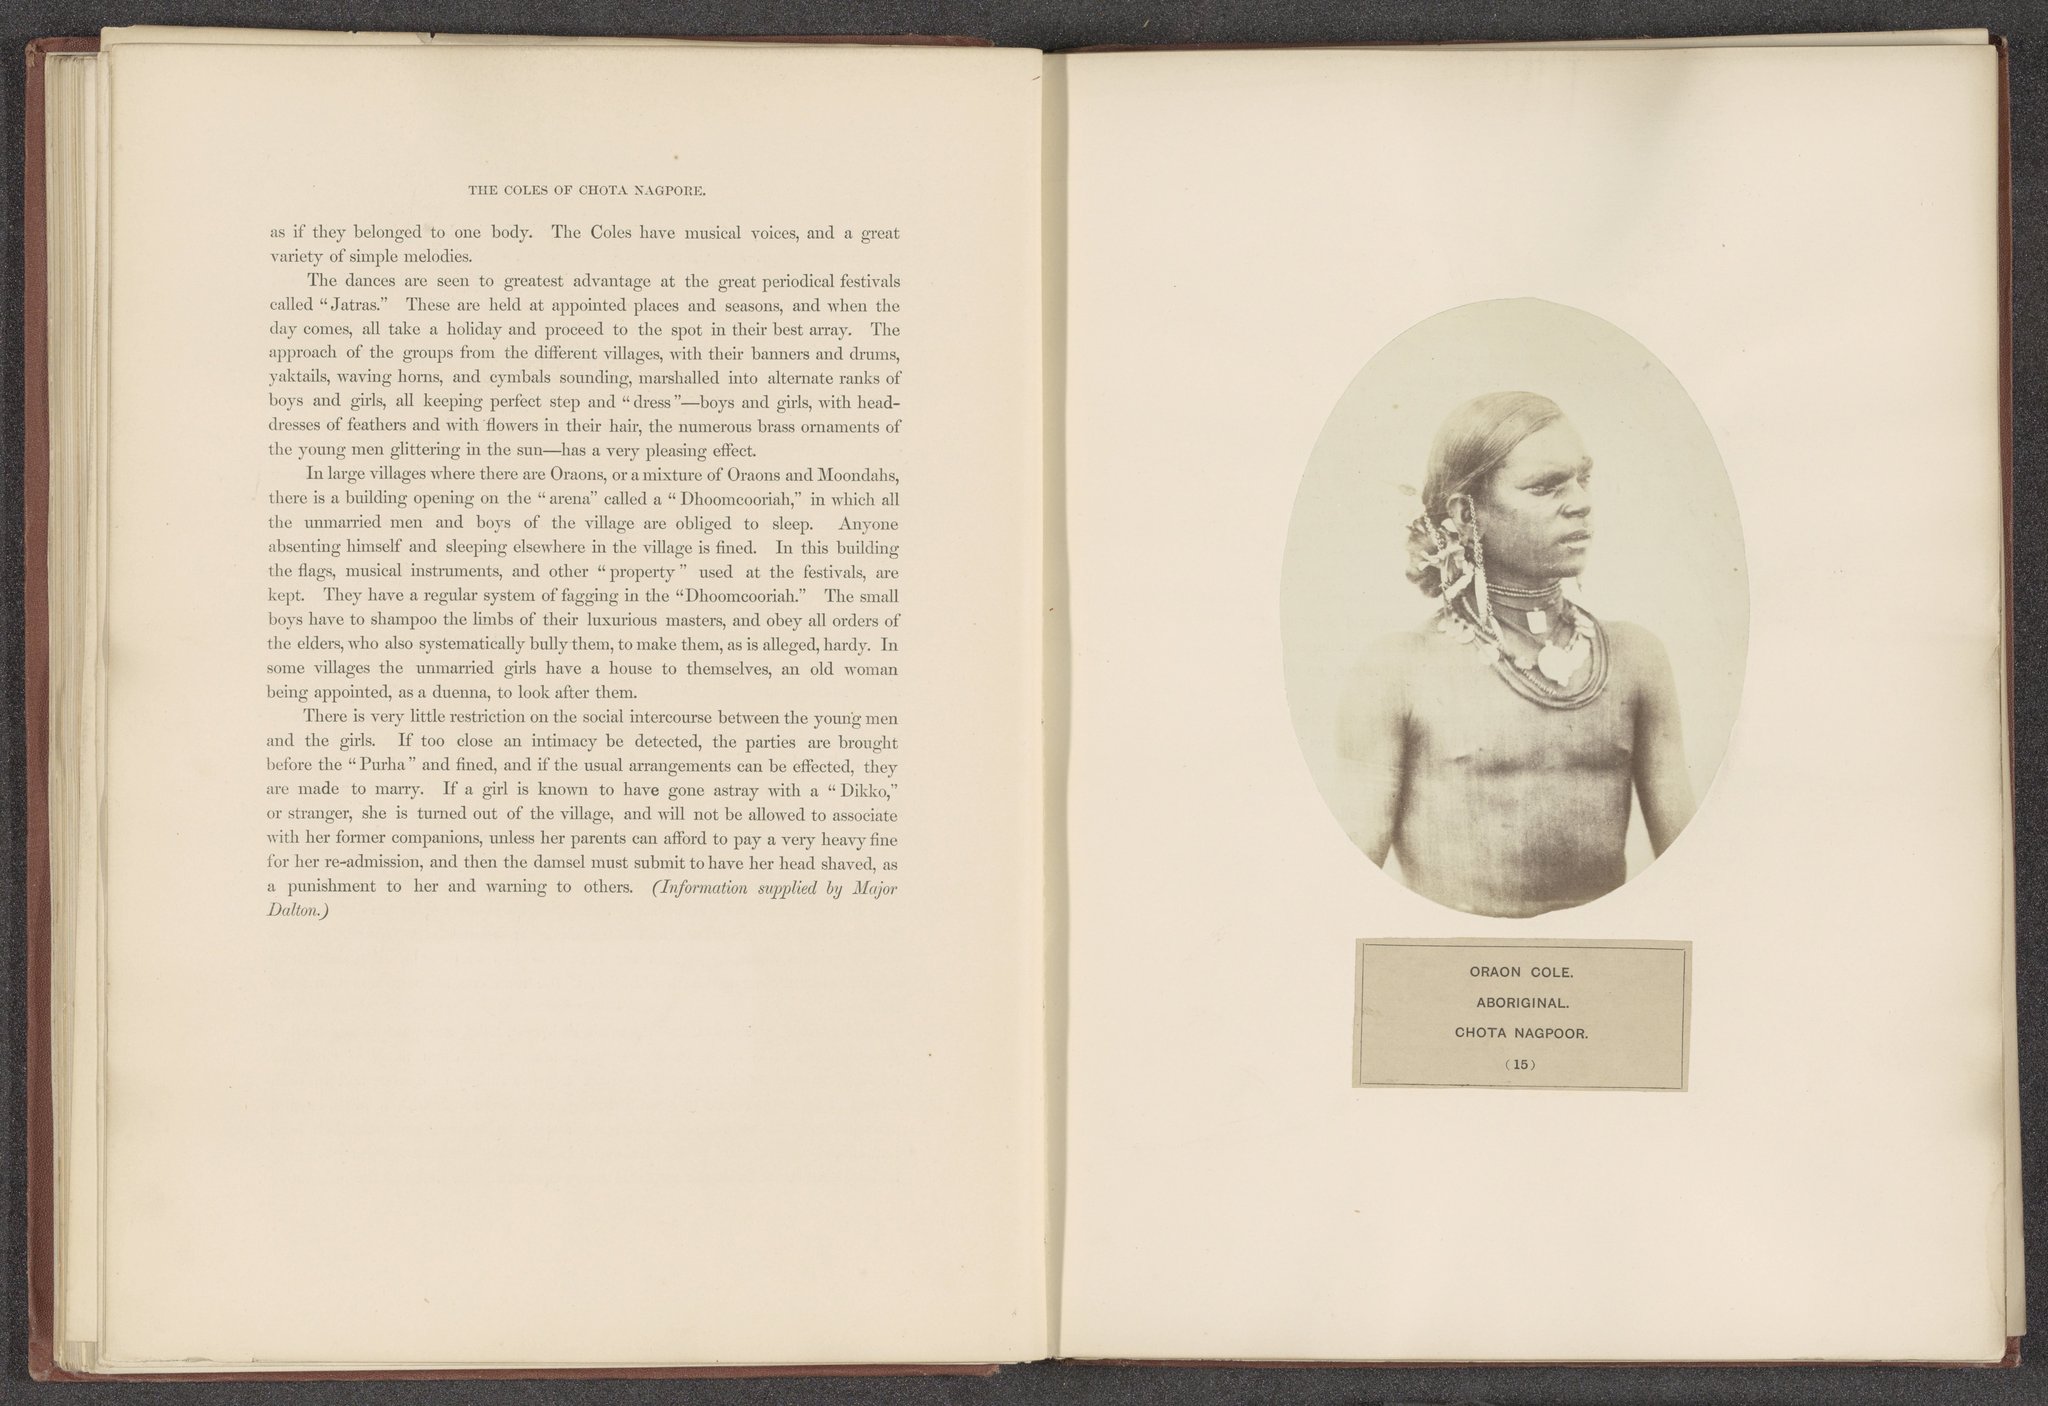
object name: page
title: Portrait of an unknown man from the Kurukh community of Chota Nagpur in eastern India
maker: benjamin simpson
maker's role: fotograaf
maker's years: 1831-1923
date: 1858-1868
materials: photographic support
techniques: albumen print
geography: chota nagpur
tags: human races; peoples; nationalities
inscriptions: inscription: ‘ORAON COLE./ ABORIGINAL./ CHOTA NAGPOOR.’, number: ‘(15)’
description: De Kurukh-gemeenschap is ook bekend als Oraon.